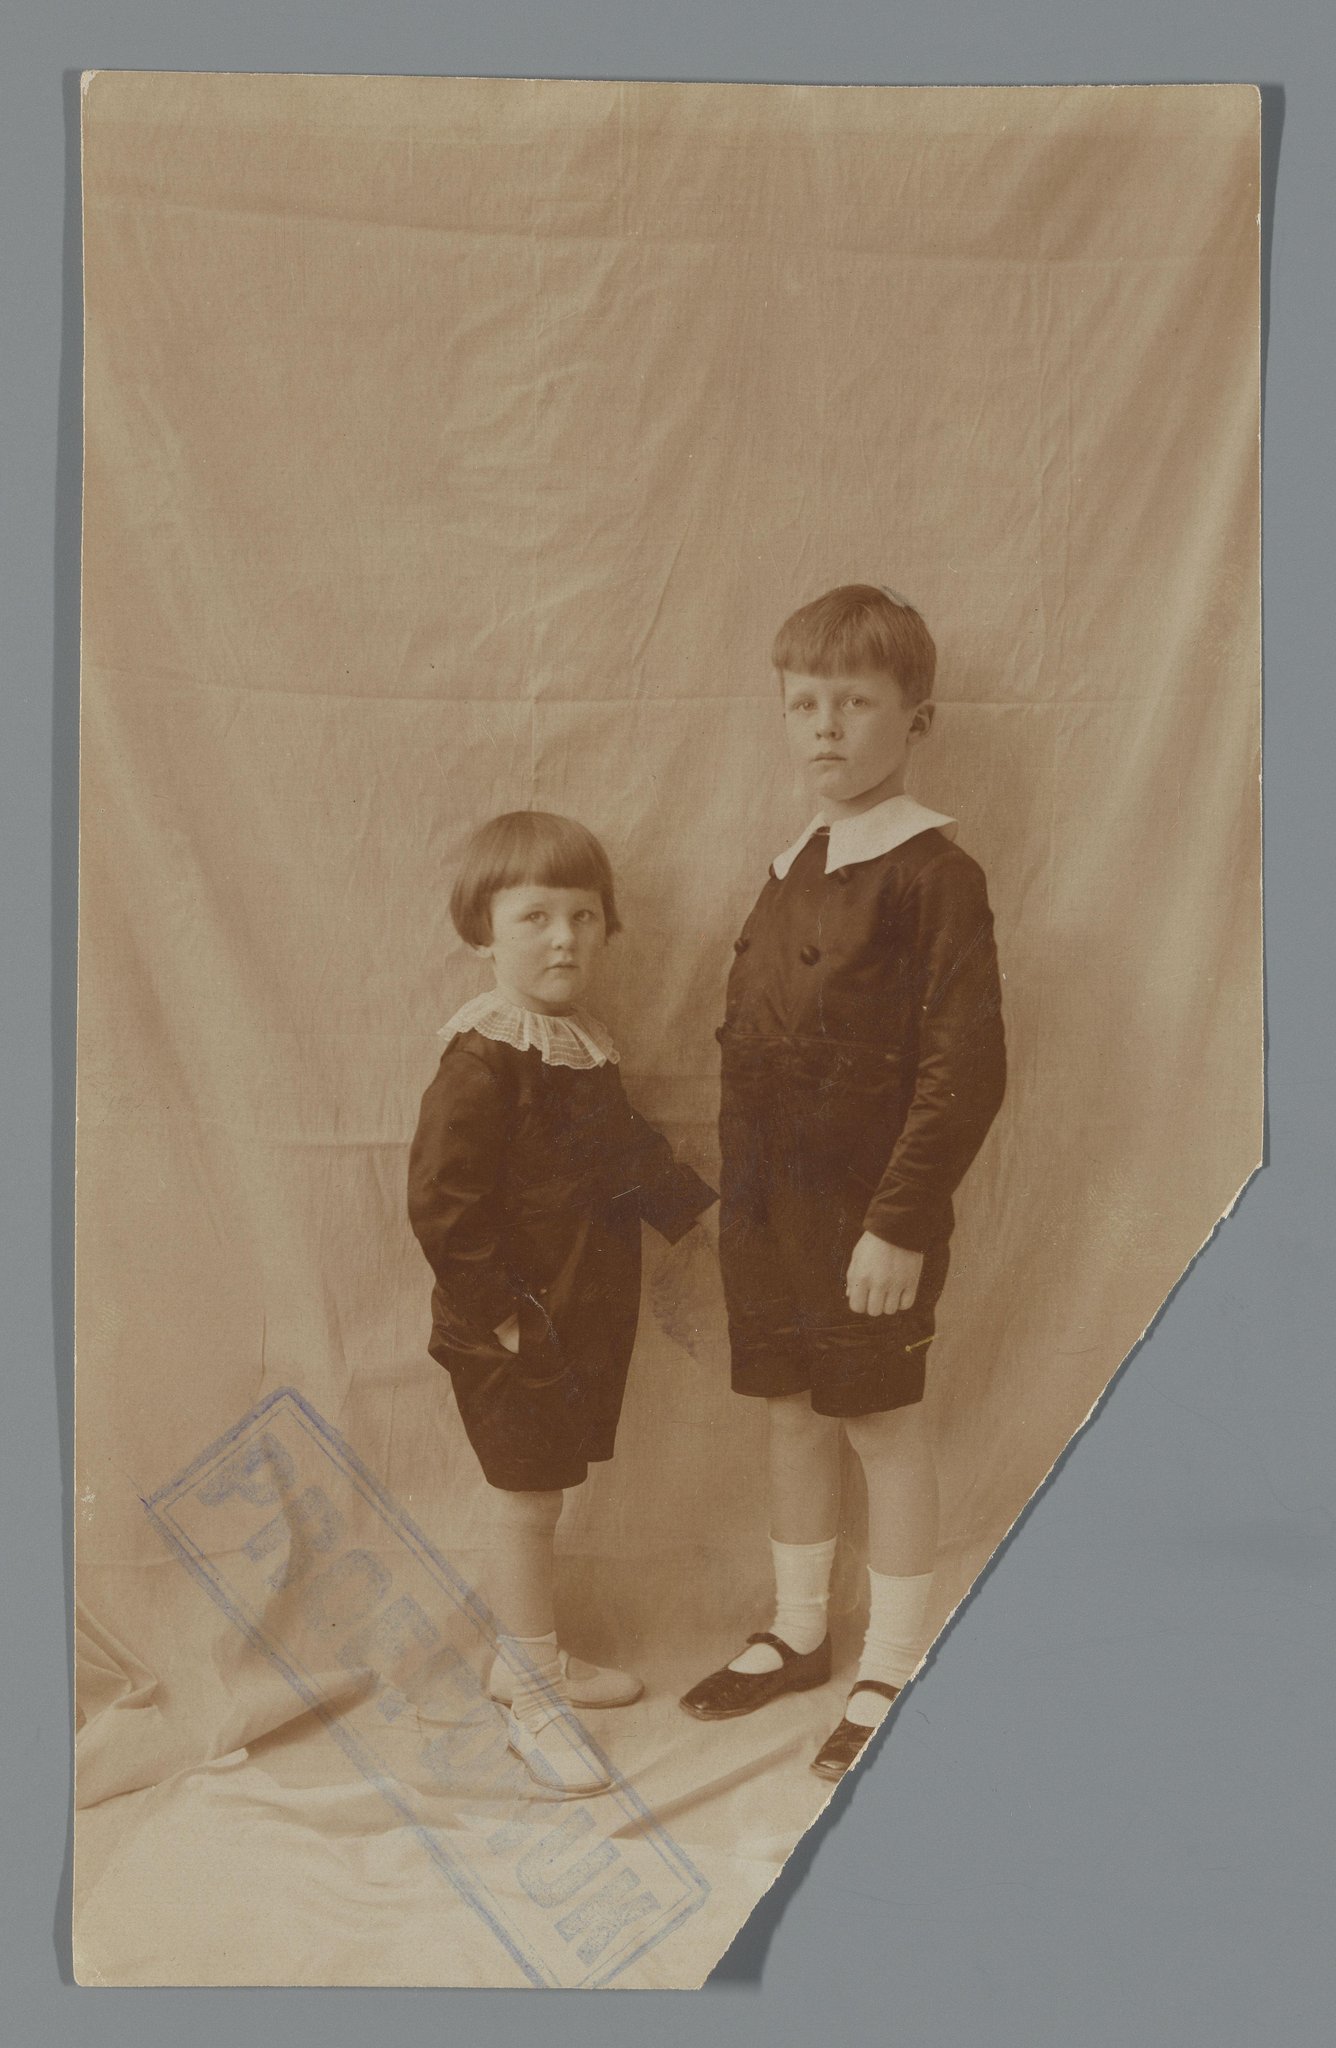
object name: photograph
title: De twee kinderen van Line van den Berg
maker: hendrik herman van den berg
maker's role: amateurfotograaf, jurist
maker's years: 1875-1944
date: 1905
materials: photographic support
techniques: photography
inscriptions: inscription: ‘Ik vind het enigszins / kinderlijk op deze photo / dat er van de oudste / maar één arm en / v/d jongste één been / zichtbaar is; maar / aangezien ik de oudste / ... bijzonder goed / ... kan ik er toch / ... een afdruk’, stamp: ‘PROEFDRUK’